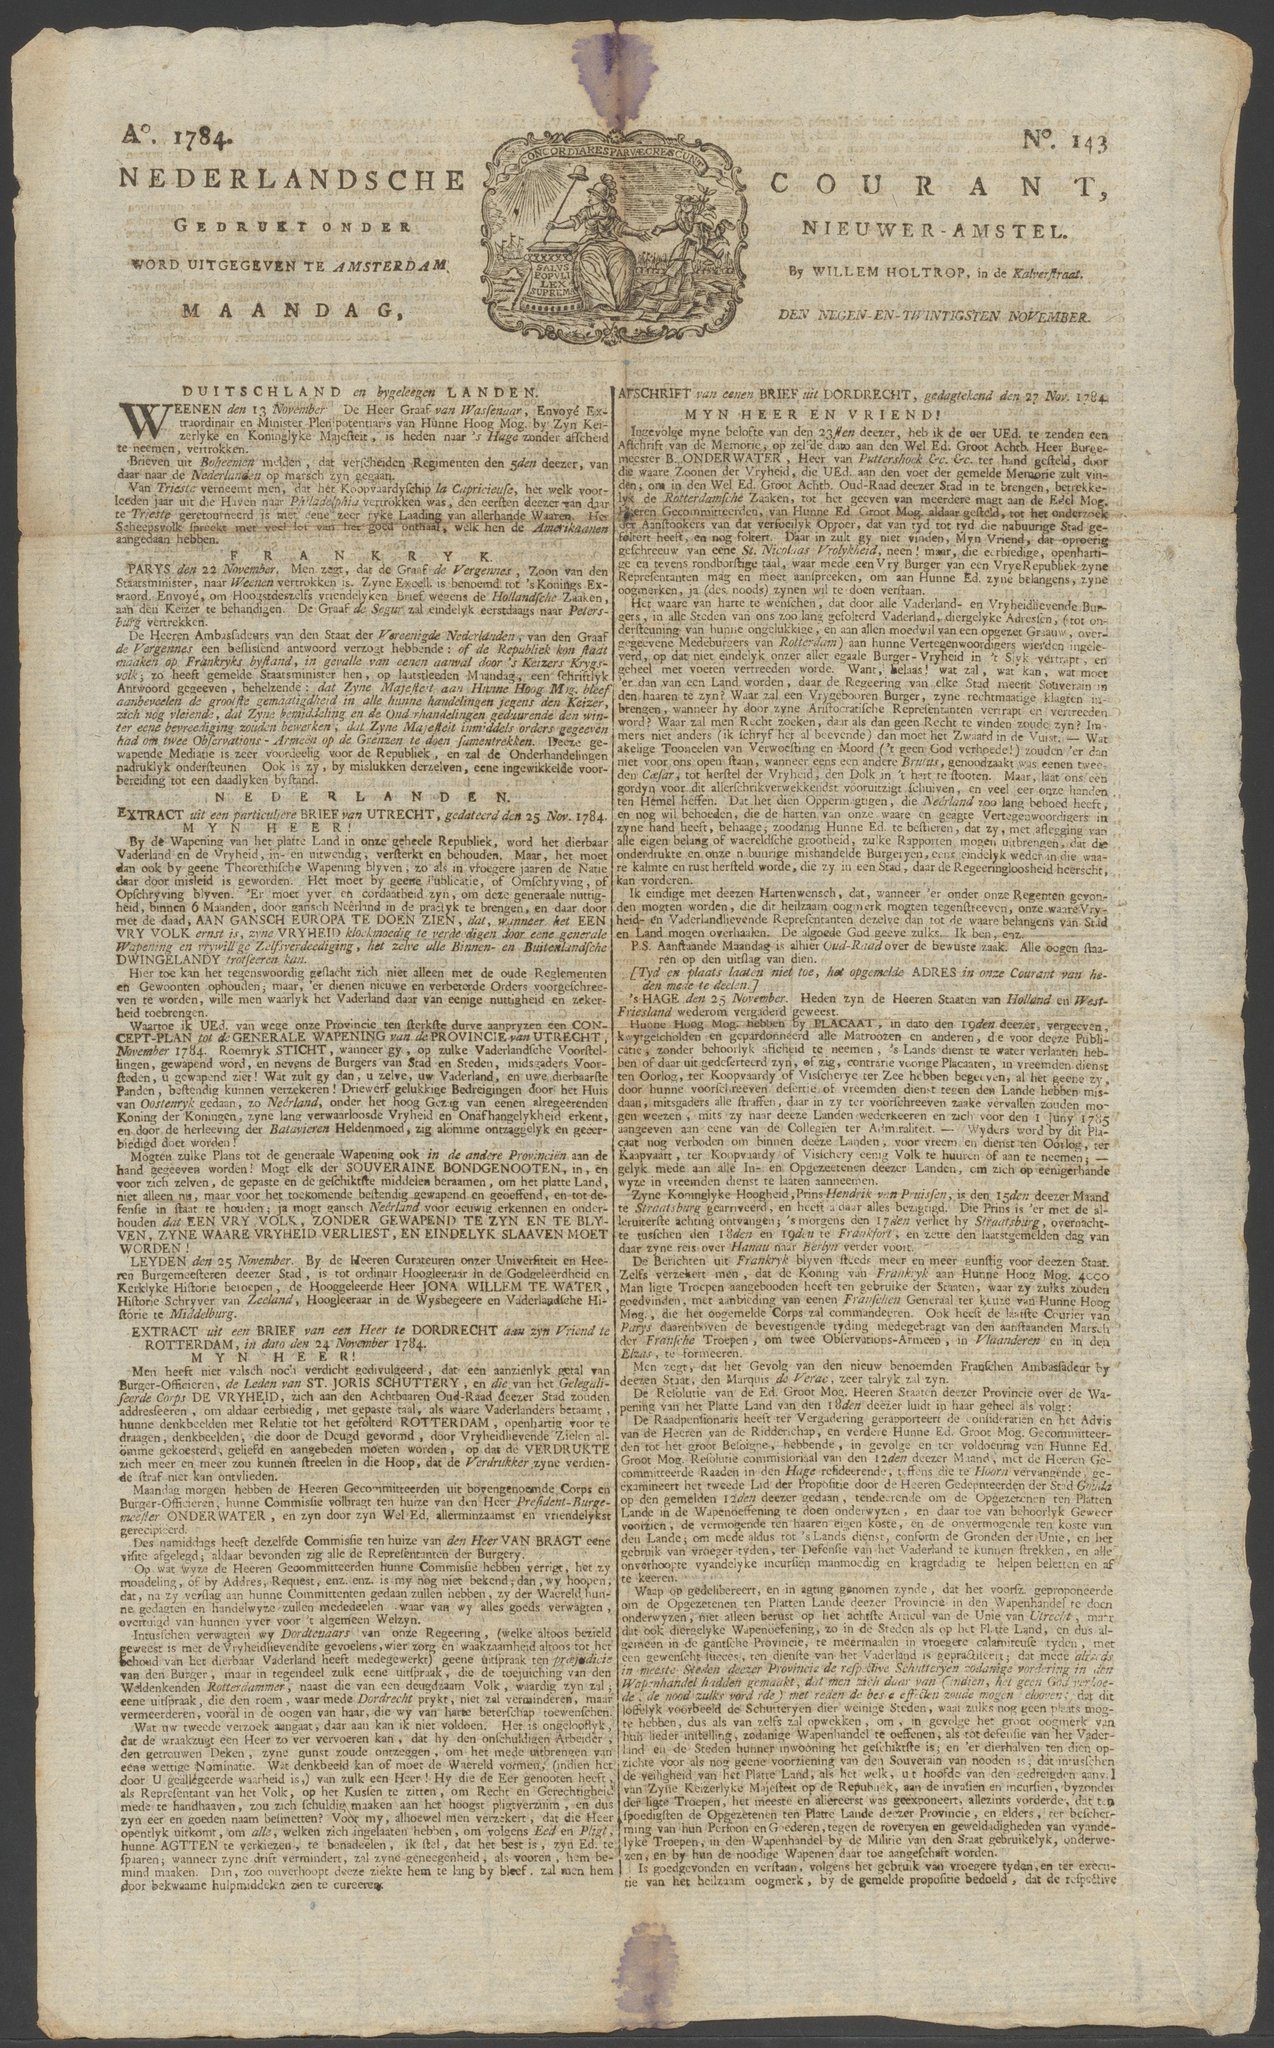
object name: newspaper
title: Nederlandsche Courant, 29 november 1784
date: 1784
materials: paper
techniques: letterpress printing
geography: nieuwer-amstel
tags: newspaper, news-sheet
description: Exemplaar van de krant 'Nederlandsche Courant' van 29 november 1784. Enkelbladig, beide zijden bedrukt. Bovenaan een vignet met de Vrijheid en Mercurius. Onderwerpsrubrieken binnen de Atlas Zeden en Gewoonten: Regeering, Officieele Nieuwsbladen.